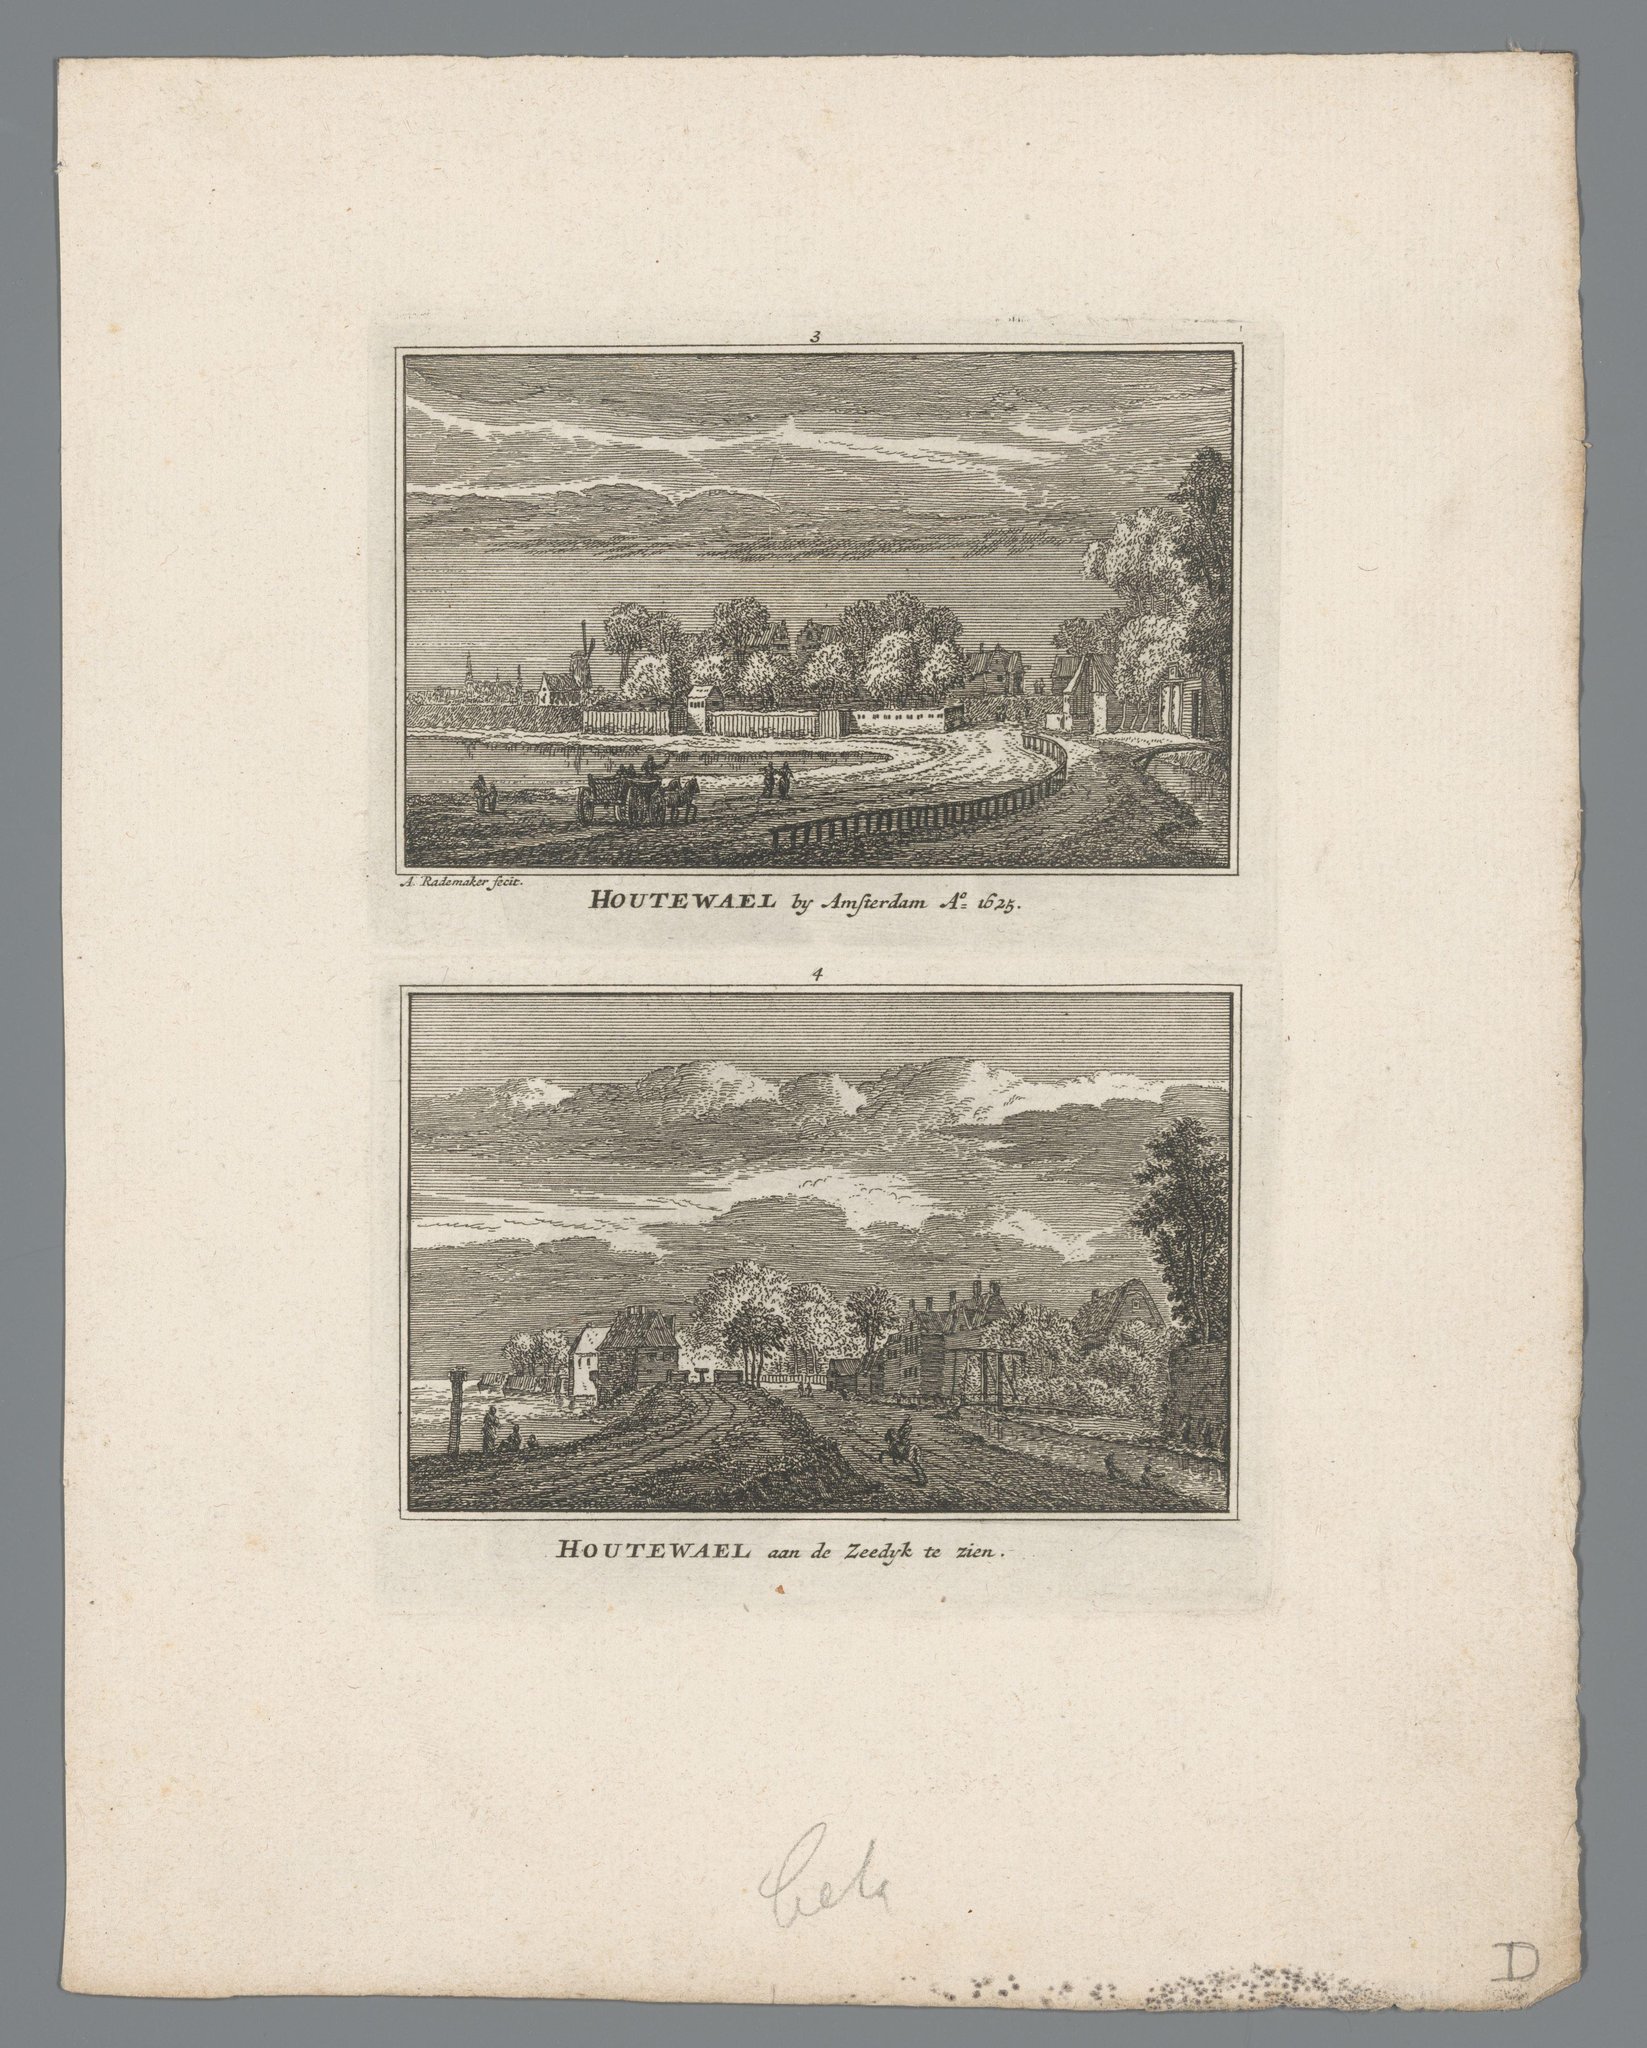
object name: print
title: Houtewael by Amsterdam Ao 1625 / Houtewael aan de Zeedyk te zien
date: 1727-1733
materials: paper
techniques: etching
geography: amsterdam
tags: prospect of village, silhouette of village, dikes, levee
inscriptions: collector's mark: Lugt 2228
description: Prent uit: Rademaker, Abraham, en Matthaeus Brouërius van Niedek, en Isaac Le Long. Kabinet van Nederlandsche en Kleefsche outheden en (...) voorname stads- en landgebouwen. Amsterdam: Willem Barents en Antoni Schoonenburg, 1727-1733, ill. nr. 3 en 4.